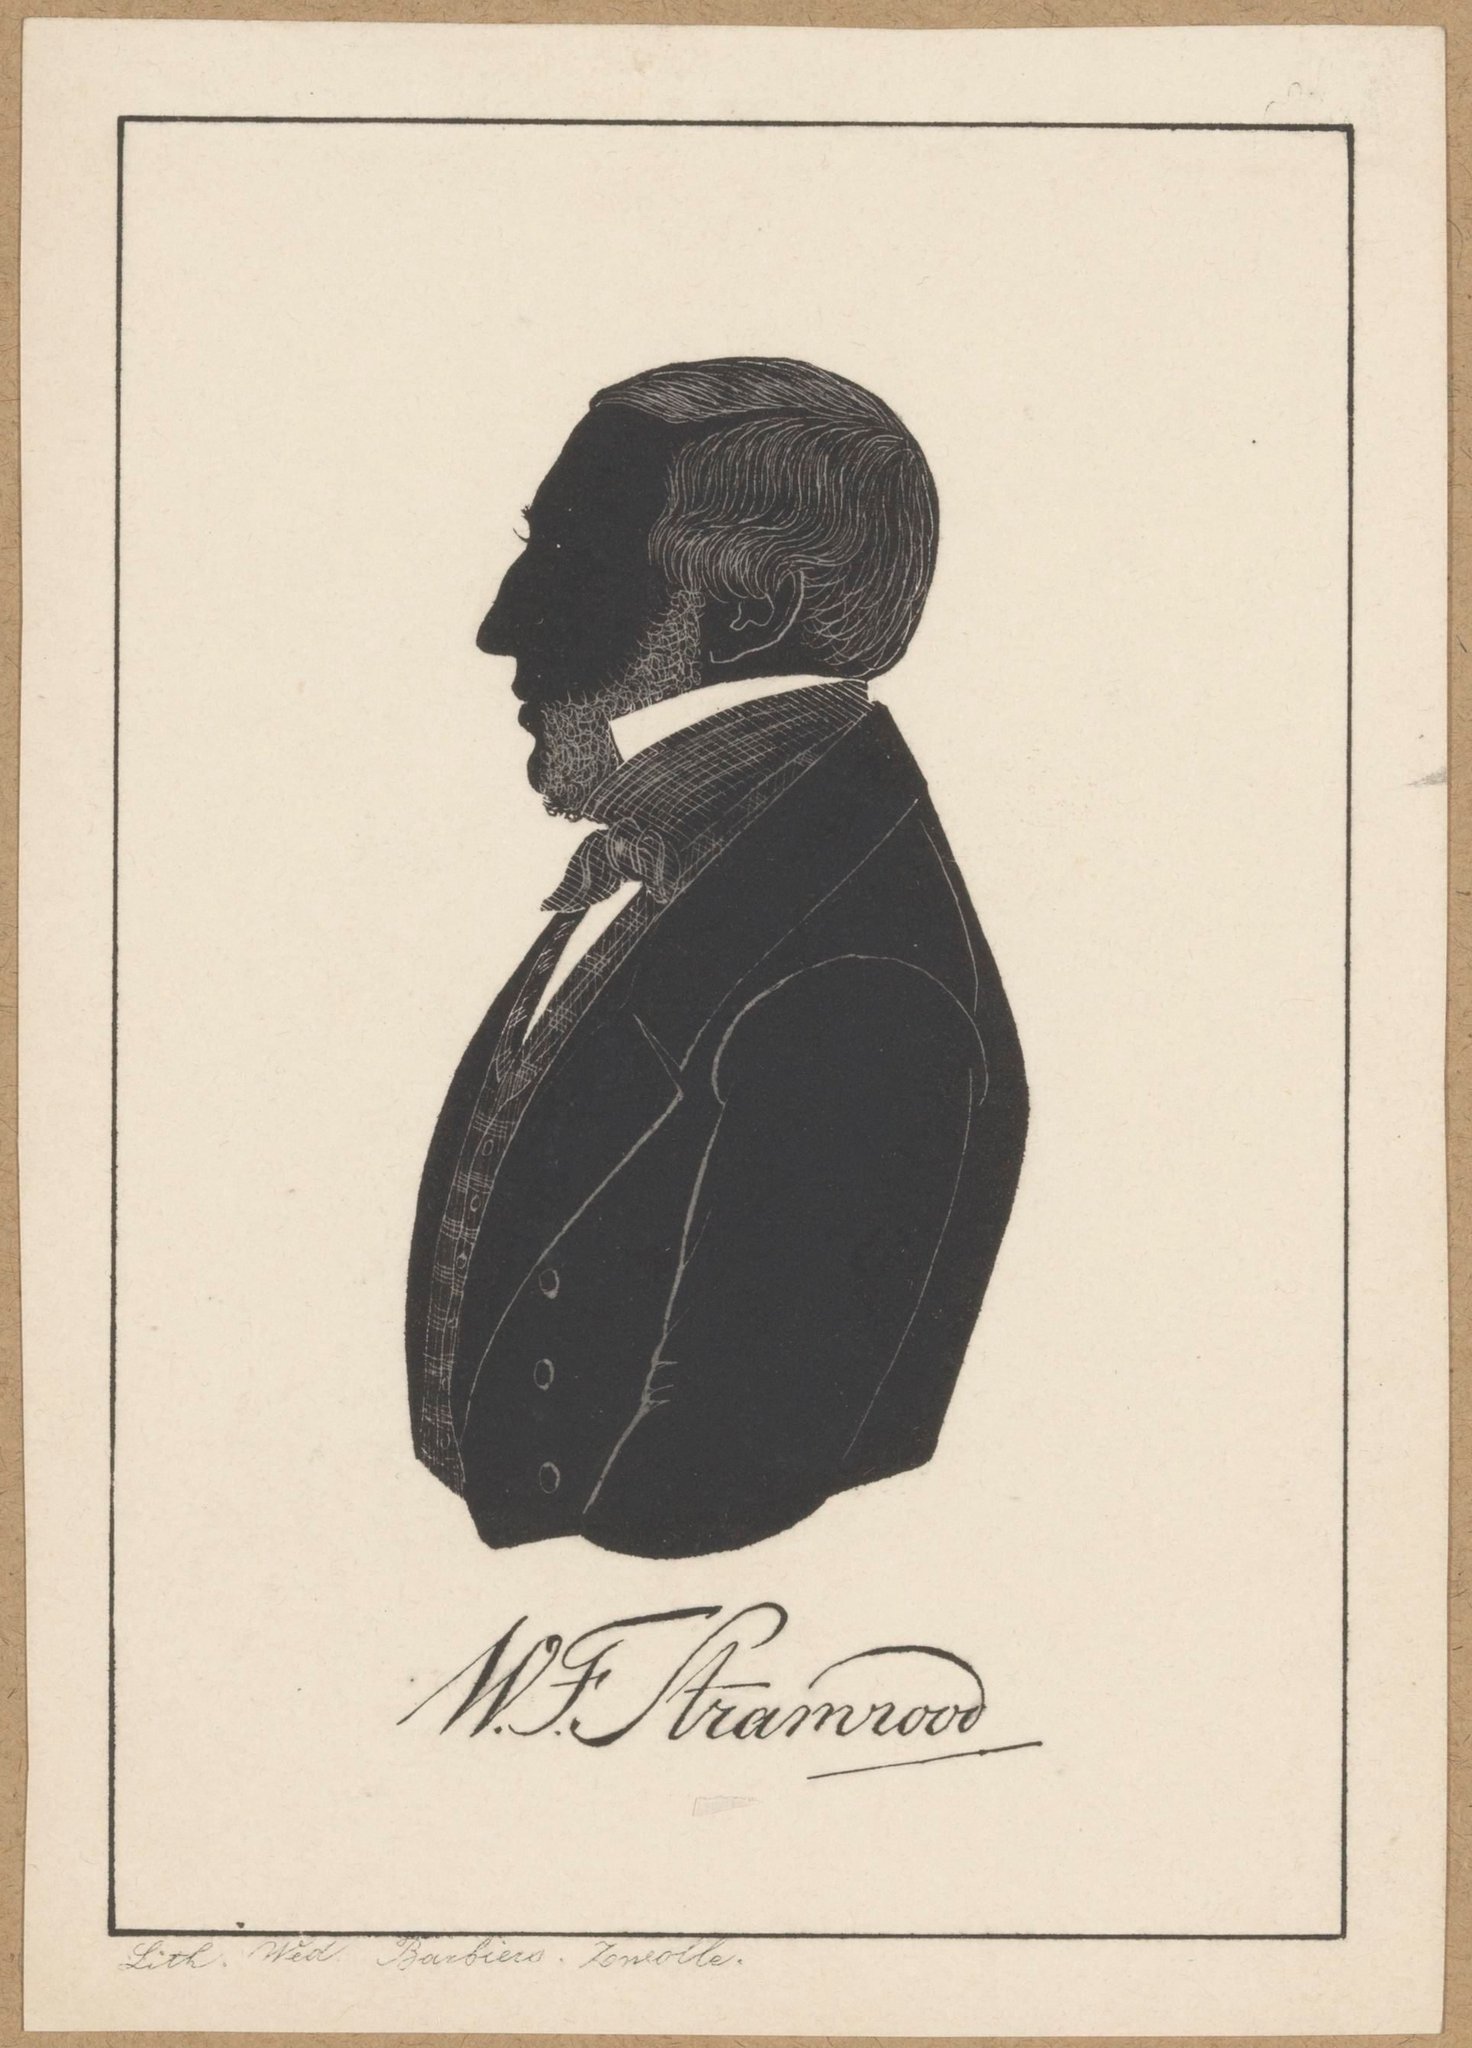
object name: print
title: Silhouetportret van W.F. Stramrood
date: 1848-1862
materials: paper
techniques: hand coloring, lithograph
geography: zwolle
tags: historical persons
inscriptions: collector's mark: Lugt 2228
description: Onder het portret de signatuur van de geportretteerde.